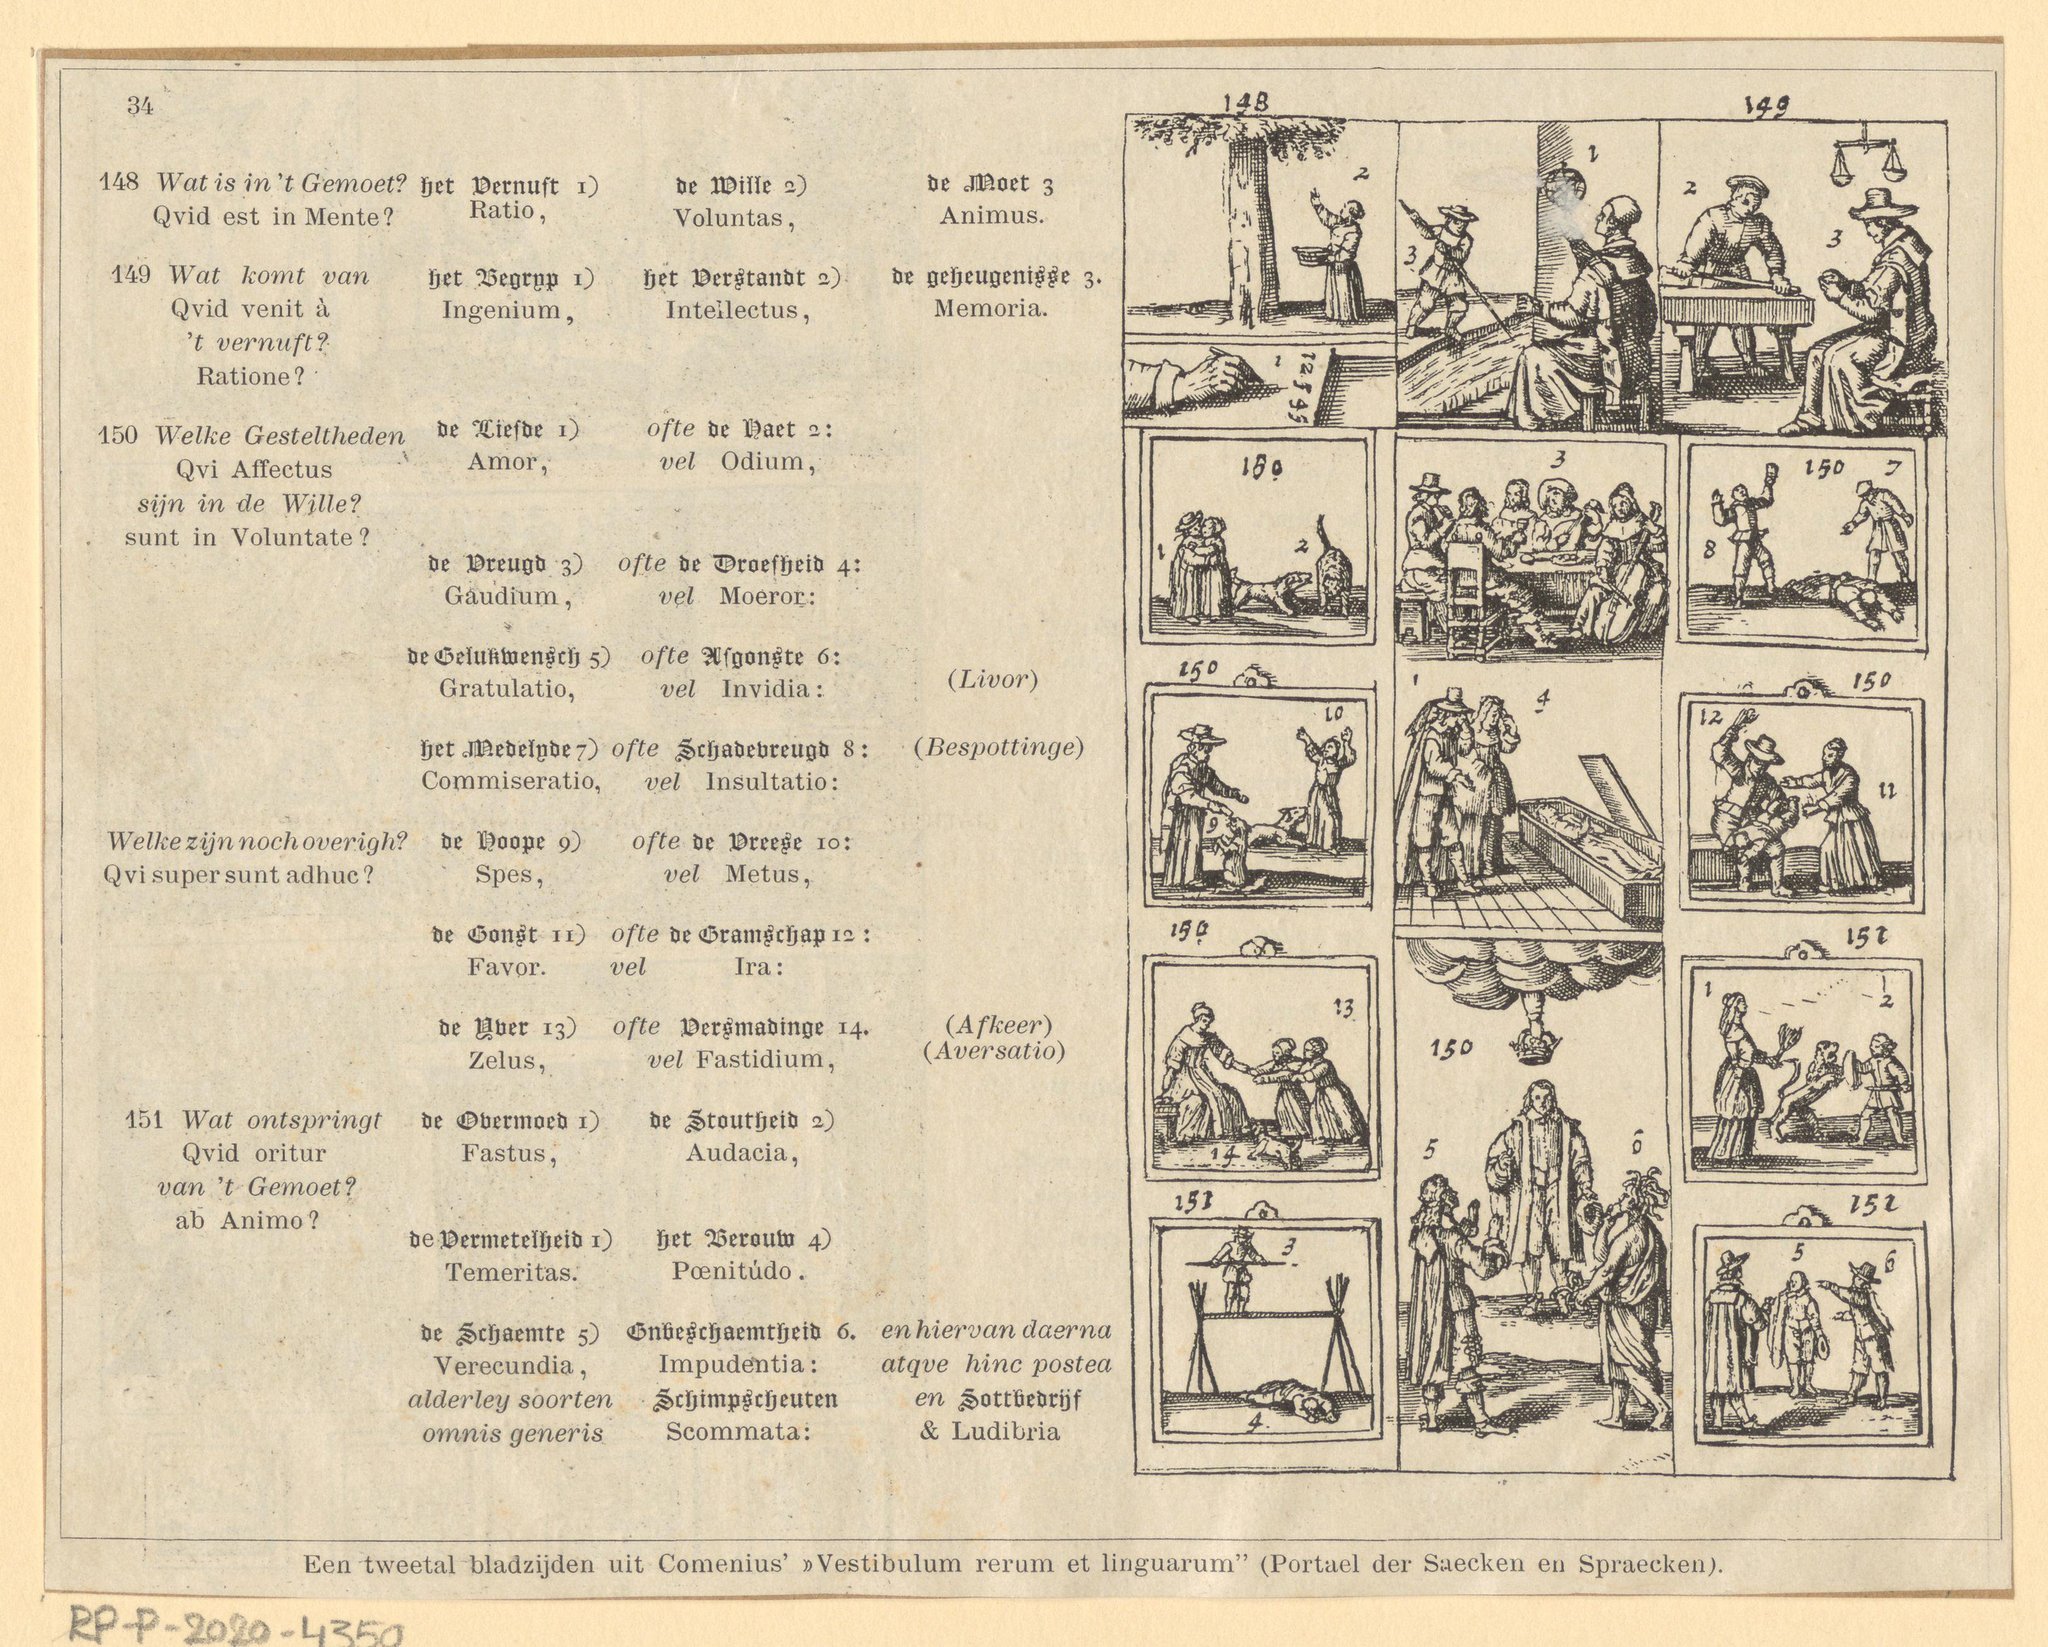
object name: photomechanical print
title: Gemoedstoestanden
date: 1892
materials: paper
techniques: letterpress printing, printing block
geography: haarlem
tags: amsterdam, hope; 'speranza', 'speranza delle fatiche' (ripa), shame, happiness, felicity, courage, bravery, valiance, manliness; 'ardire magnanimo et generoso', 'gagliardezza', 'valore', 'virtù heroica', 'virtù dell'animo e del corpo' (ripa)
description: Prent uit: Eigen haard, nr. 13, 1892. Cliché gemaakt naar afbeelding uit: Comenius, Jan Amos. Portael der saecken en spraecken (...). Amsterdam: Gabriel de Roy, 1658.